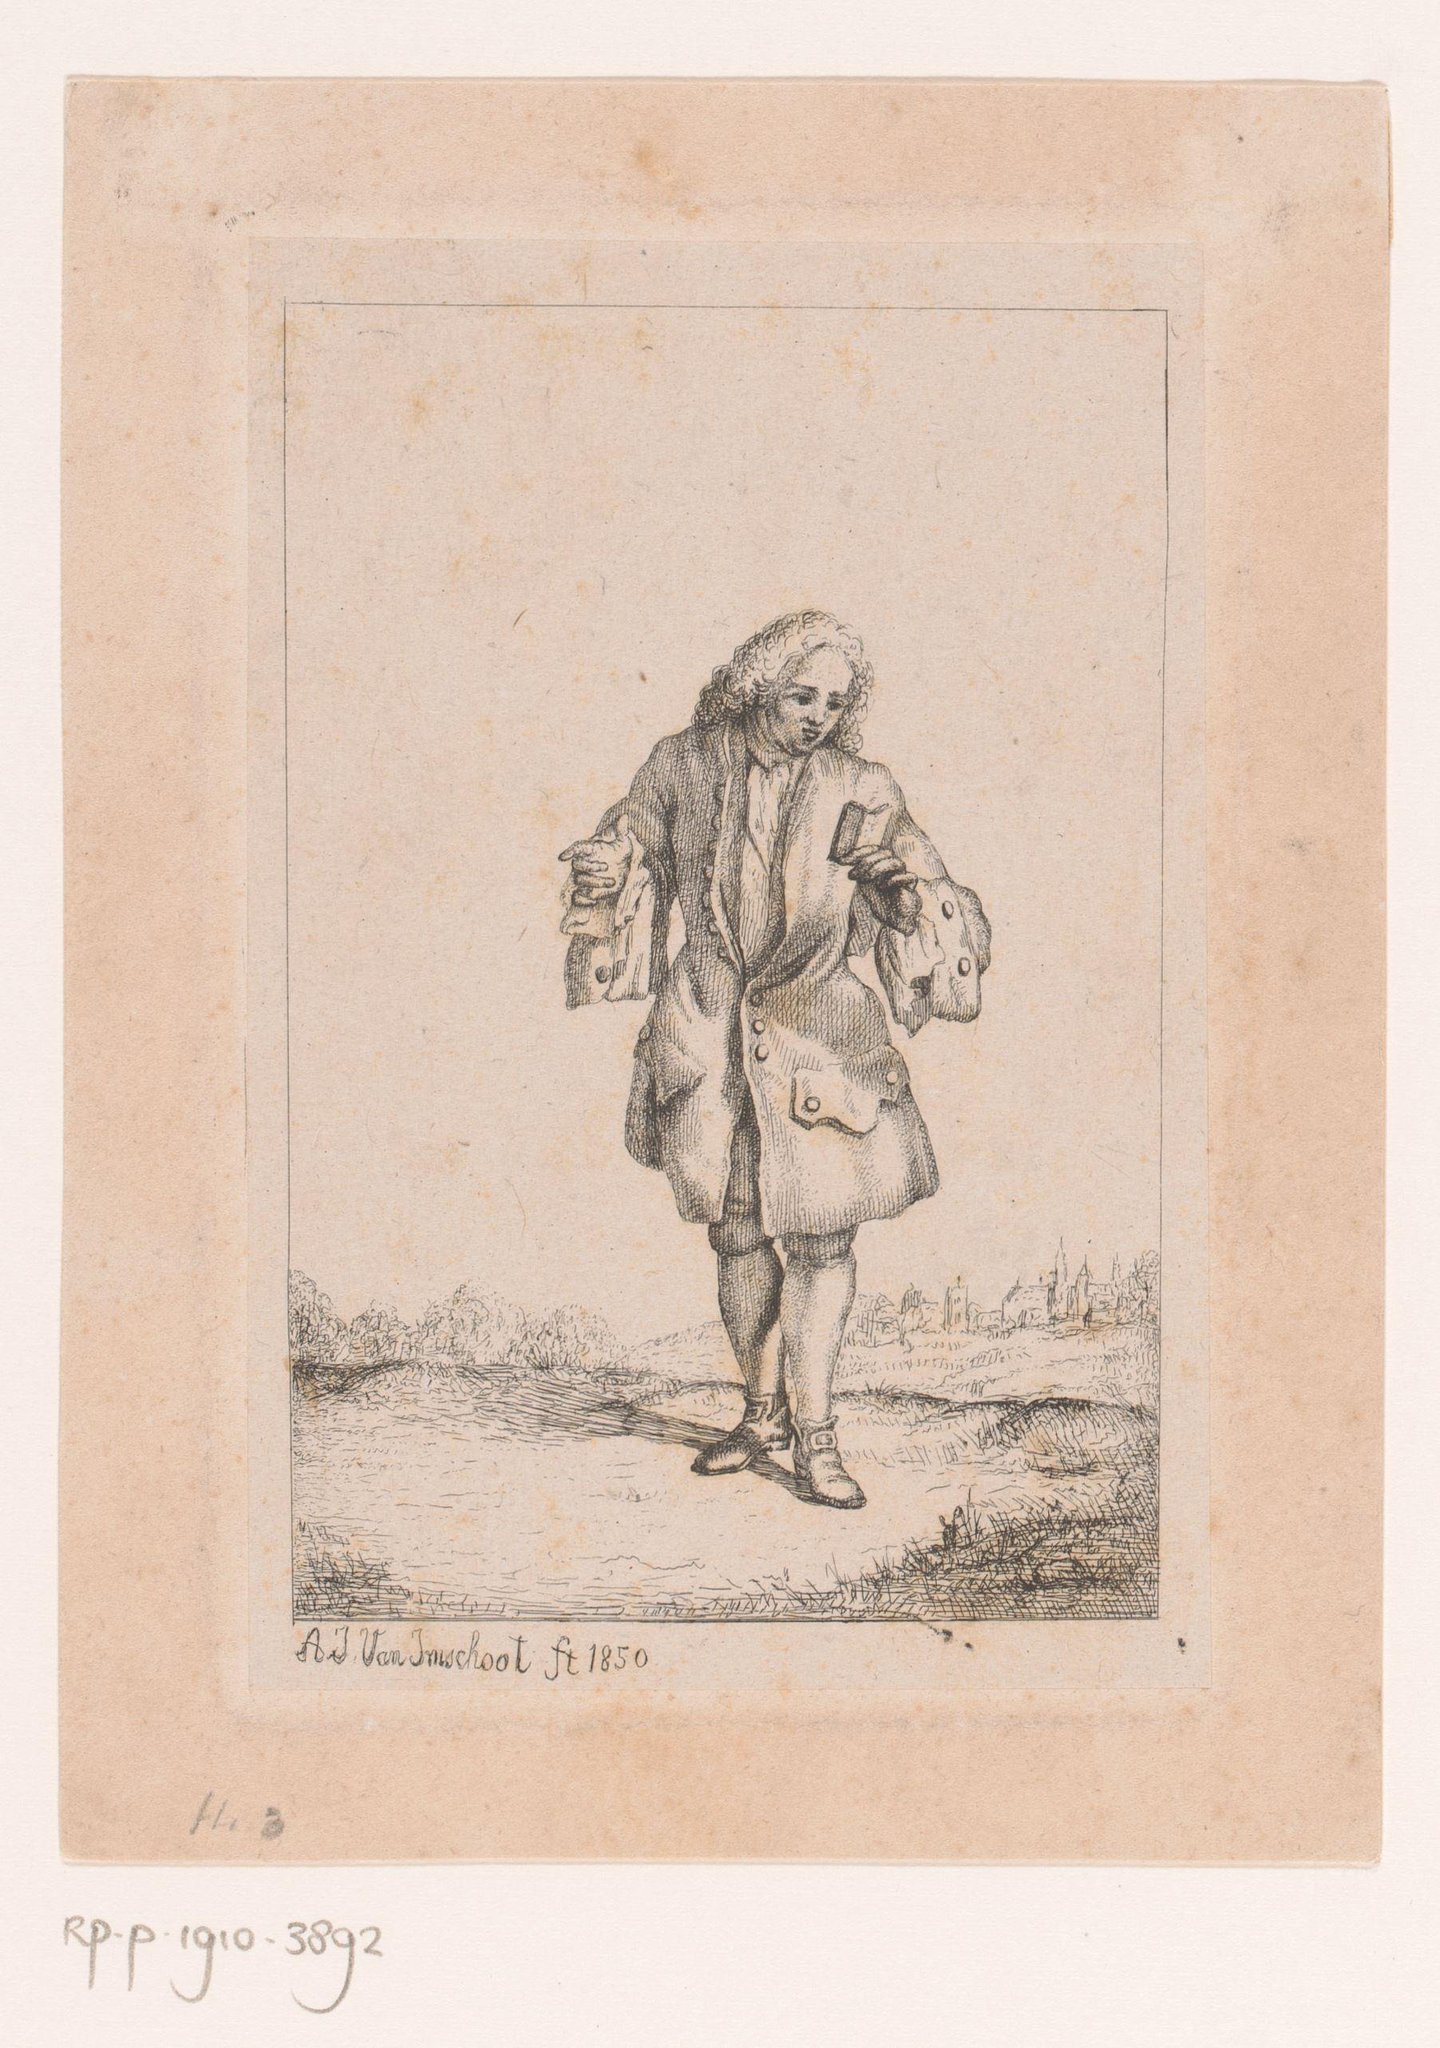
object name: print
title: Staande heer in een landschap leest een klein boek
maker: jules van imschoot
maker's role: print maker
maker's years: 1821-1884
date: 1850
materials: paper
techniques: etching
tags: reading, landscapes (+ landscape with figures, staffage)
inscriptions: collector's mark: Lugt 2228, collector's mark: Lugt 1485